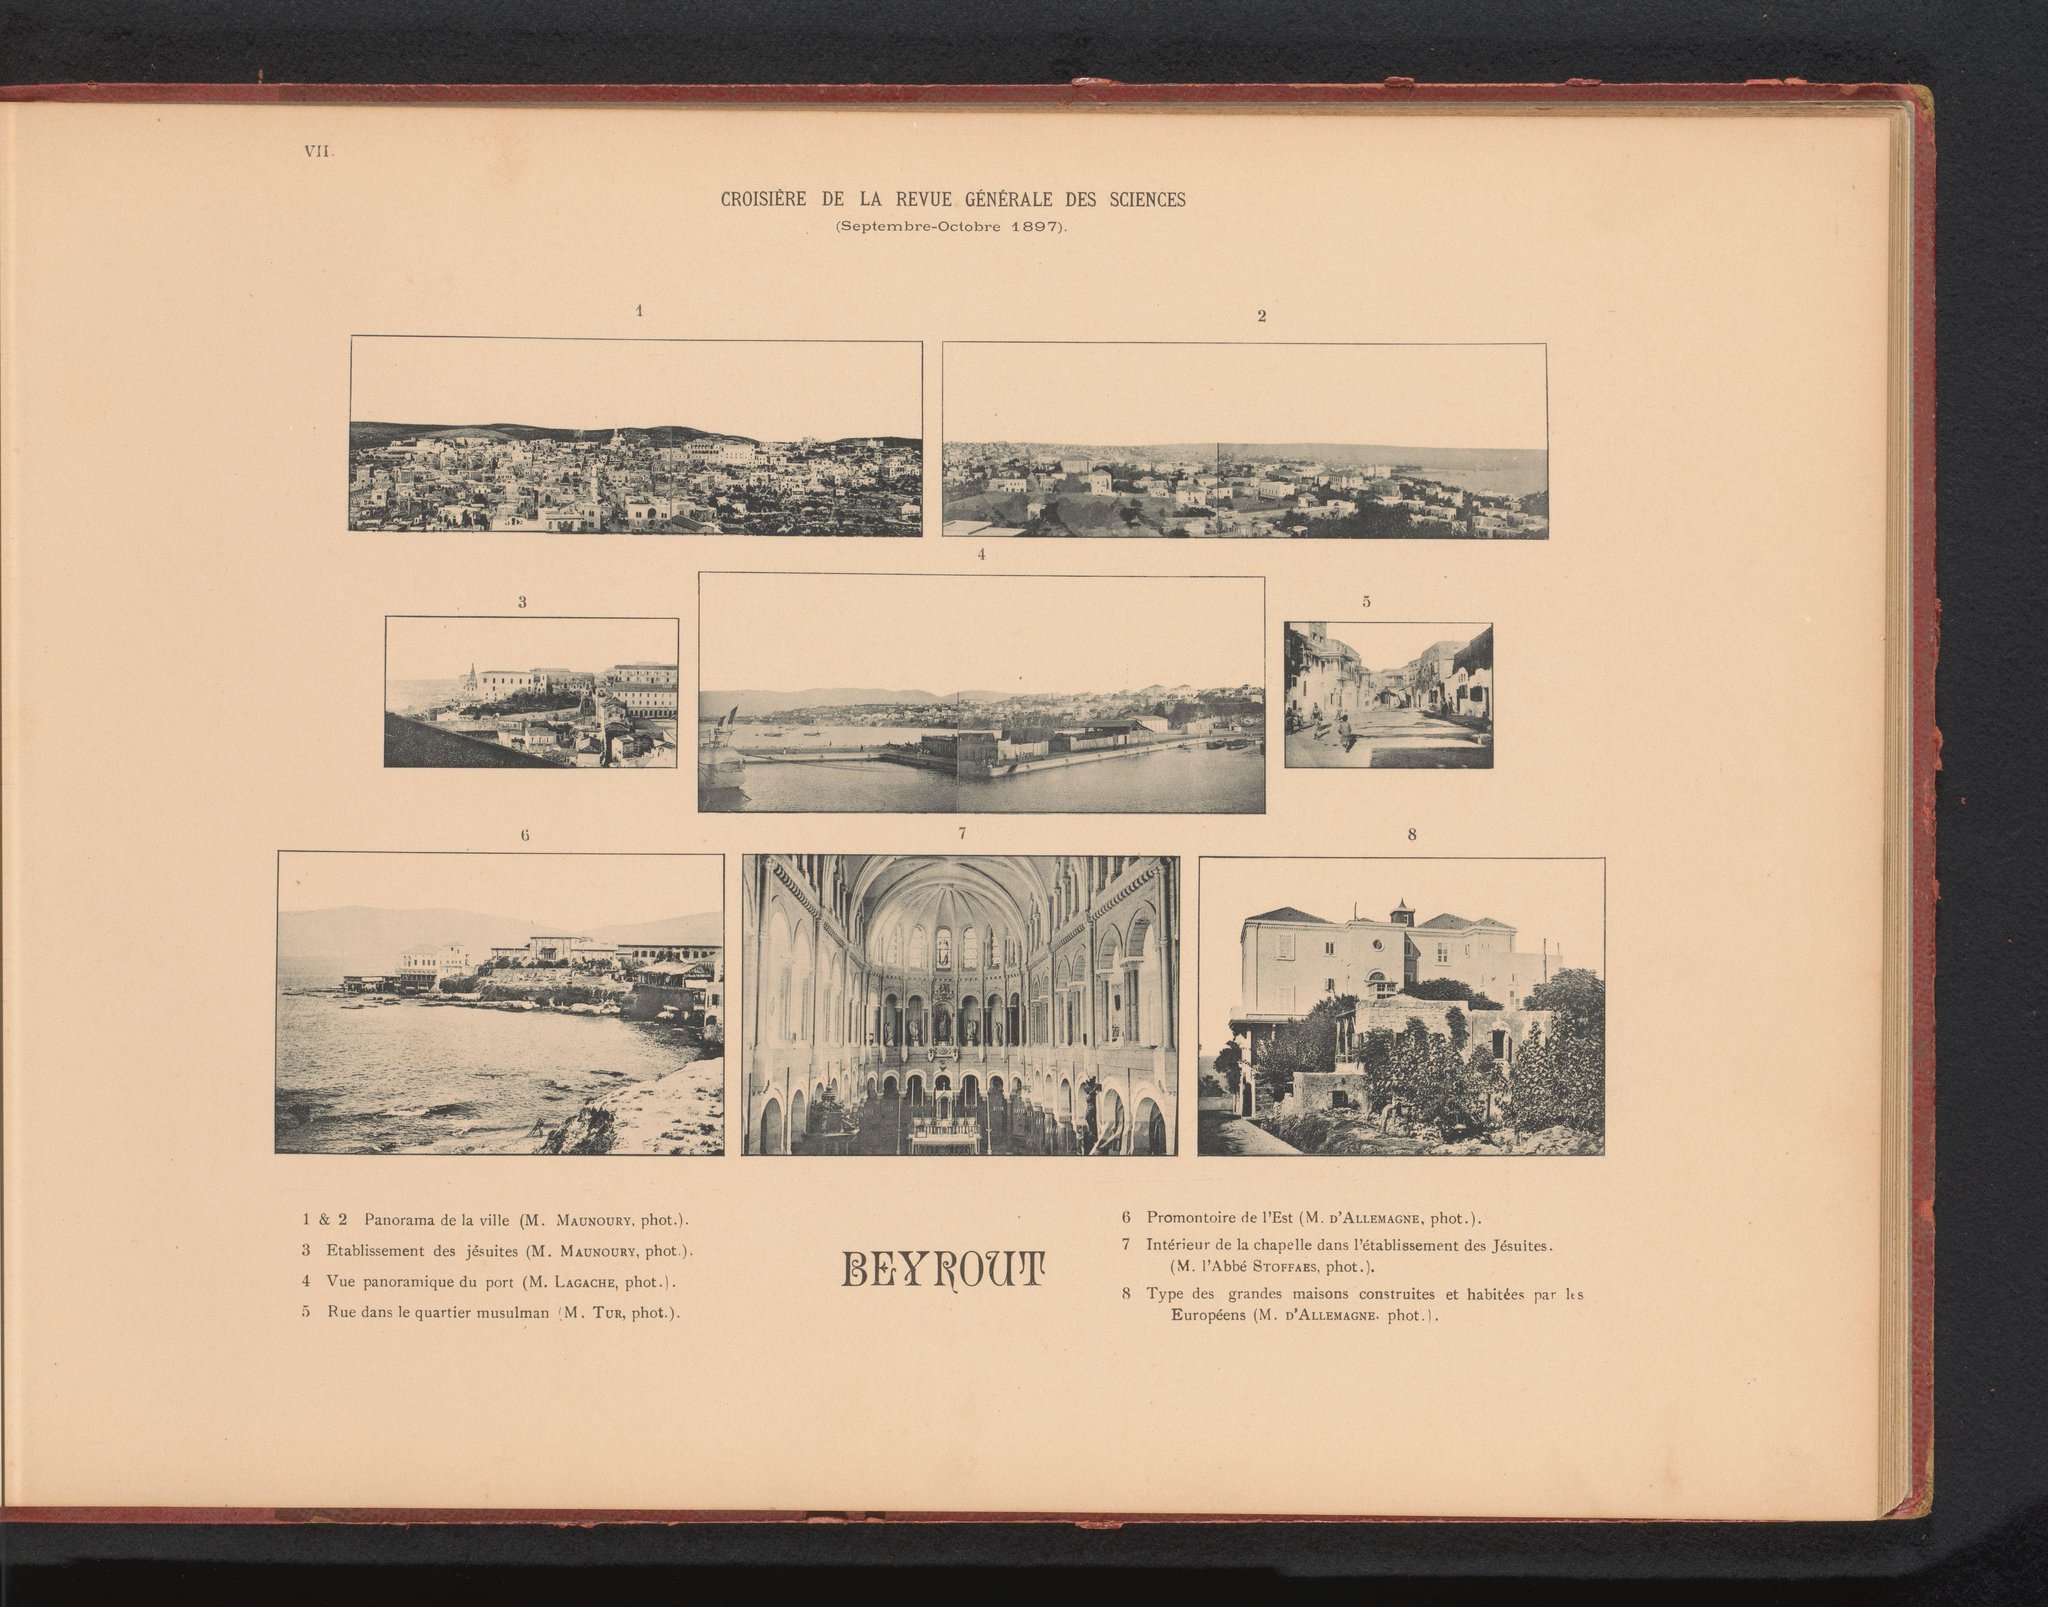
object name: photomechanical print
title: Famagouste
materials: paper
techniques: photograph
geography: ammóchostos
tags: prospect of village, silhouette of village, ruin of a building ~ architecture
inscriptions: number: ‘VI.’, inscription: ‘1 Ruines de la Cathédrale gothique./ (M. Salleron, phot.)./ 2 Palmiers et ruine d'église./ (M. Hegener, phot.)./ 3 Maisons turques autour des ruines./ (M. d'Allemagne, phot.)./ 4 Palmiers au milieu des ruines./ (M. Hegener, phot )./ 5 Restes d'une ancienne basilique chrétienne./ (M. Jules Calas, phot.)./ 6 Le Lion de Venise./ (M. d'Allemagne, phot.)./ 7 Viaduc conduisant aux remparts./ (M. Ch. Diehl, phot.).’